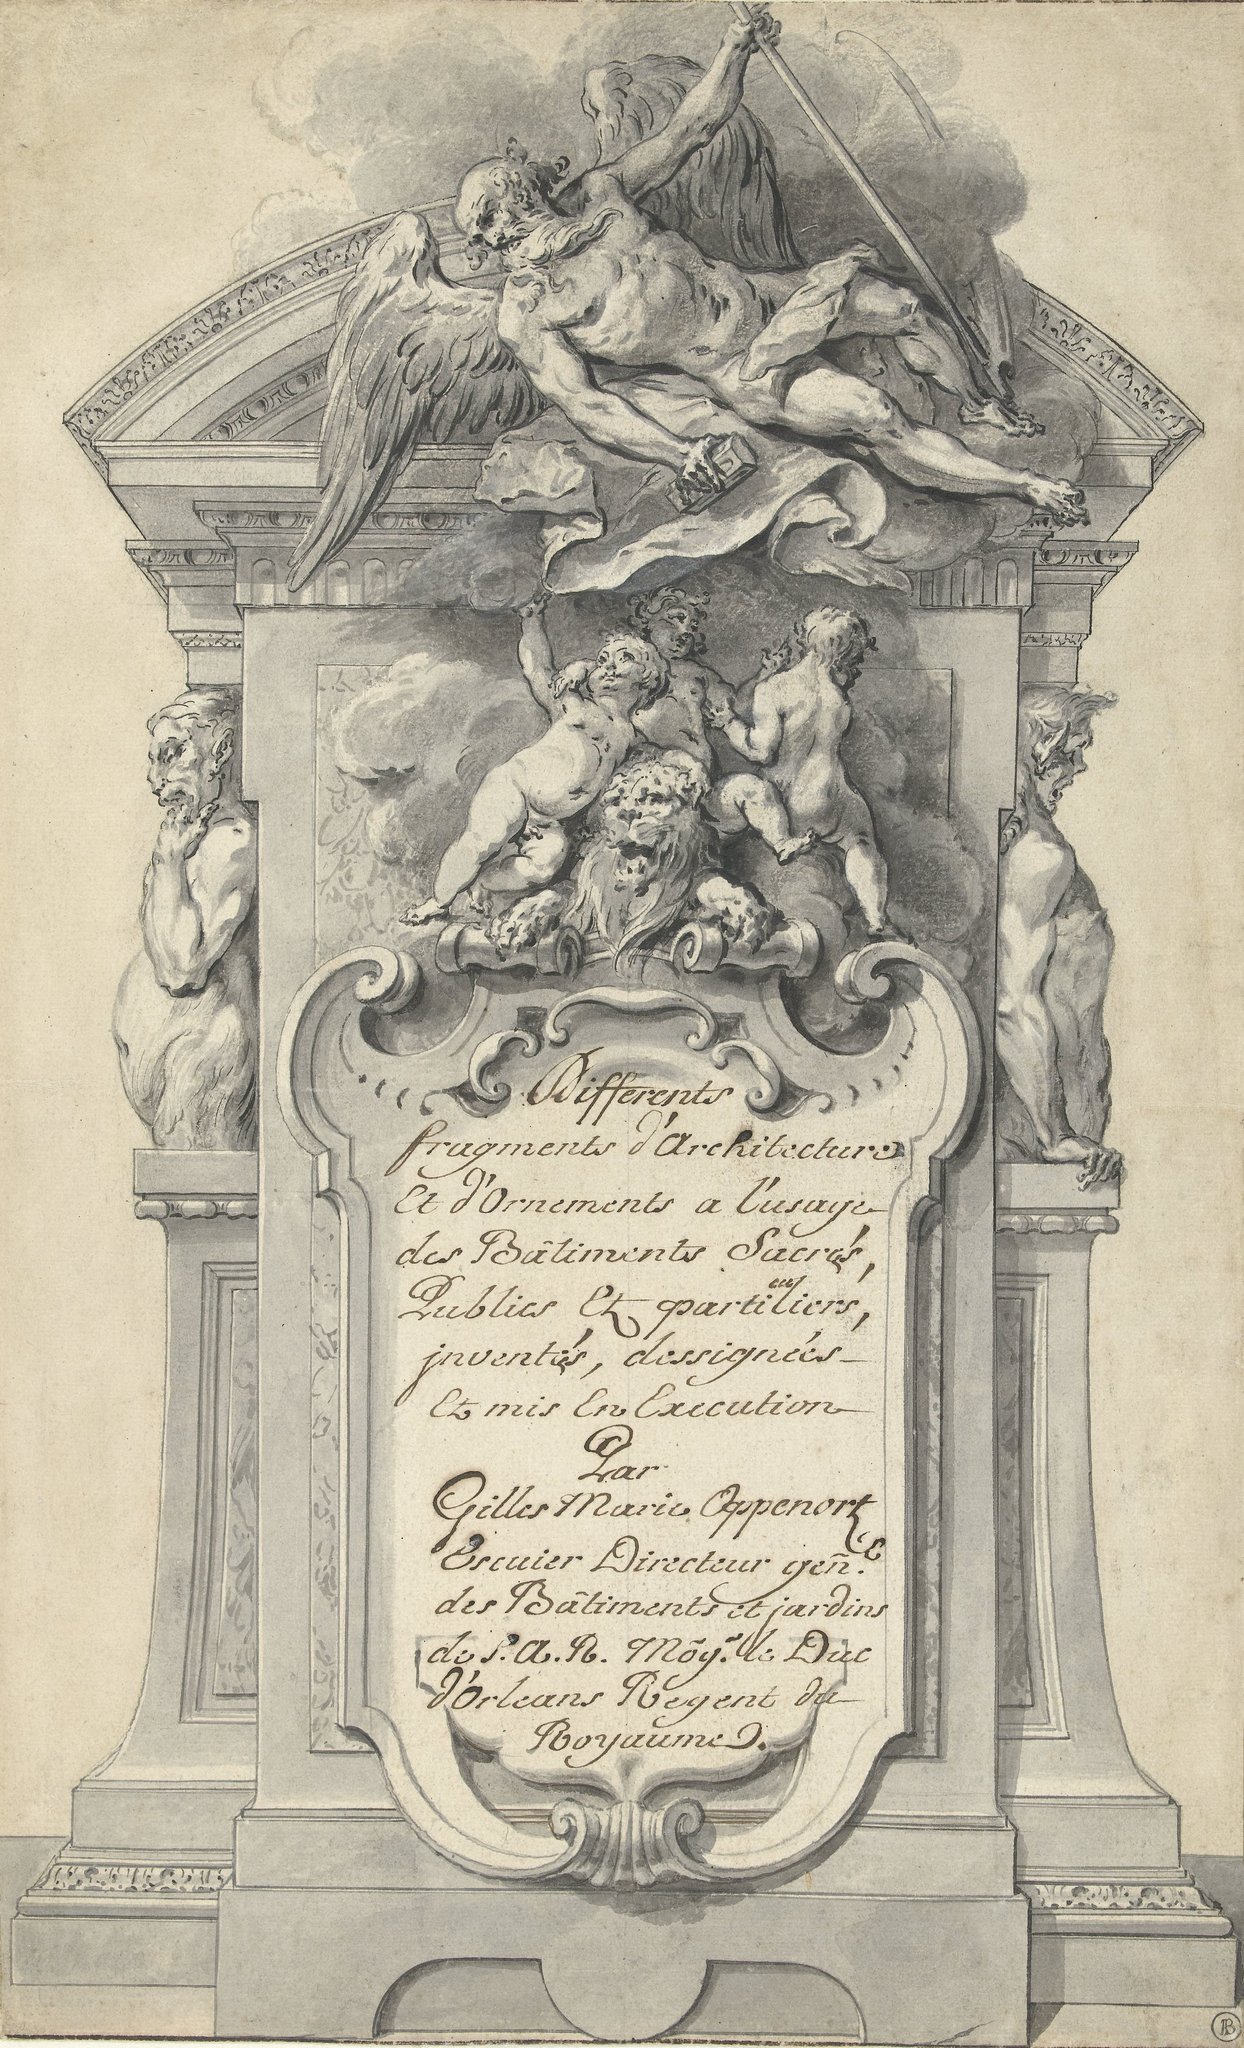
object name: design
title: Ontwerp voor een titelblad met de Tijd boven een cartouche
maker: gilles marie oppenort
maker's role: draughtsman, print maker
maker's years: 1672-1742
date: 1740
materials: chalk, ink, paper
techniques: brush, pen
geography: paris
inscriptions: collector's mark, recto, lower right: Lugt 75, inscription, recto, centre, pen and brown ink: ‘Differents / fragments d'Architecture / Et d'Ornements a l'usage / des Batiments Sacrés, / Publics et parti[cu]liers, / inventés, dessignées / Et mis En Execution / Par / Gilles Marie Oppenort, / Escuier Directeur gen[eral] / des Batiments et jardins / de S.A.R. Mo[nsei]g[neur] le Duc / d'Orleans Regent du / Royaume.’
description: Bovenaan bevindt zich de Tijd, daaronder drie putti en een leeuw boven een cartouche met tekst. Ontwerp voor het titelblad van een reeks prenten naar tekeningen van de kunstenaar, de zogenaamde Grand Oppenord.